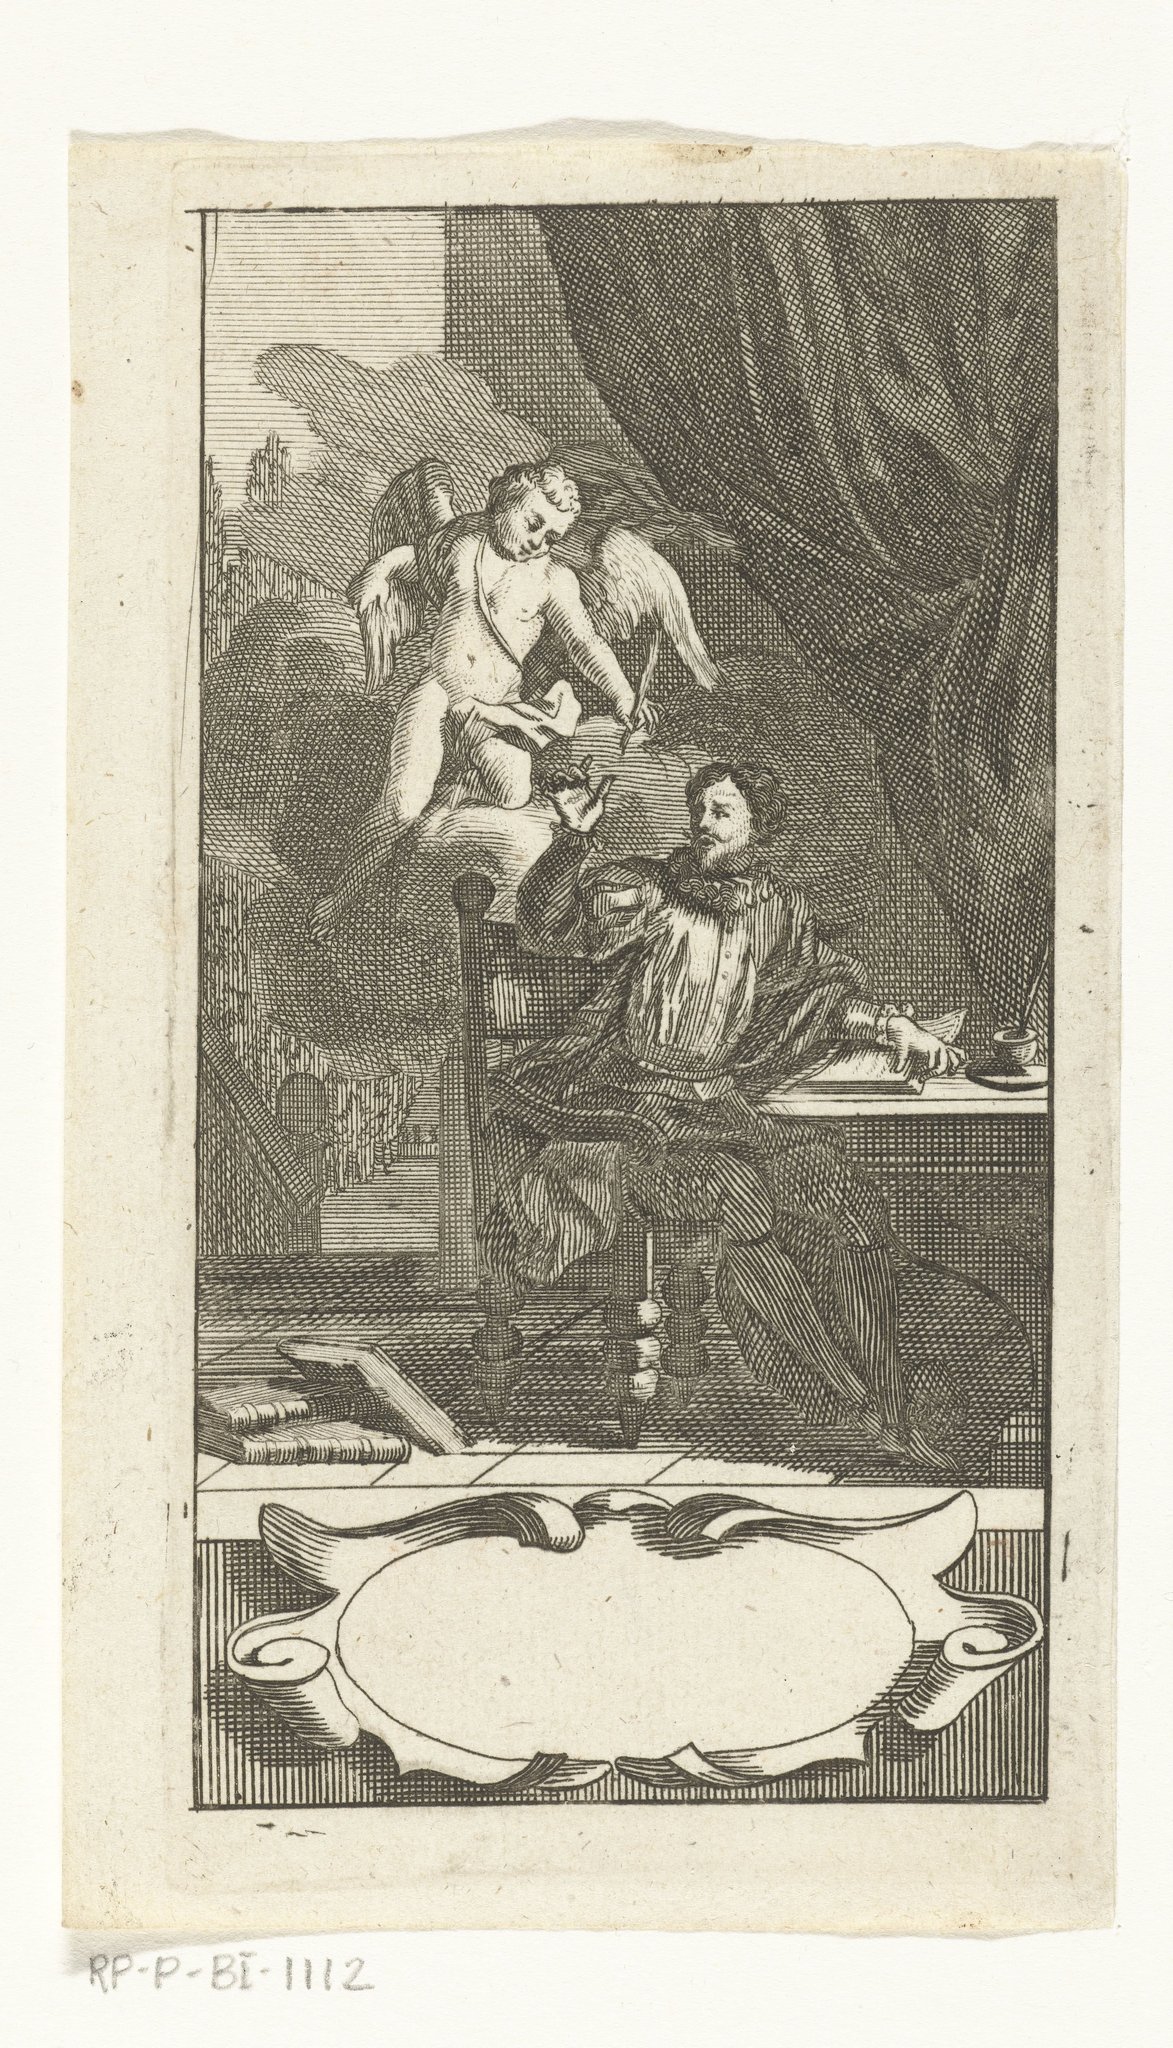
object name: print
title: Titelprent met man die inspiratie ontvangt van engeltje boven lege cartouche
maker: jan baptist berterham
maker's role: print maker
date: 1696-1721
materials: paper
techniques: etching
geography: brussels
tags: inspiration of the artist (in general)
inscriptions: collector's mark: Lugt 2228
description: Titelprent met man zittend aan tafel, hij krijgt een pen aangereikt van een engeltje op een wolk als teken van zijn (goddelijke) inspiratie. Daaronder een lege cartouche.